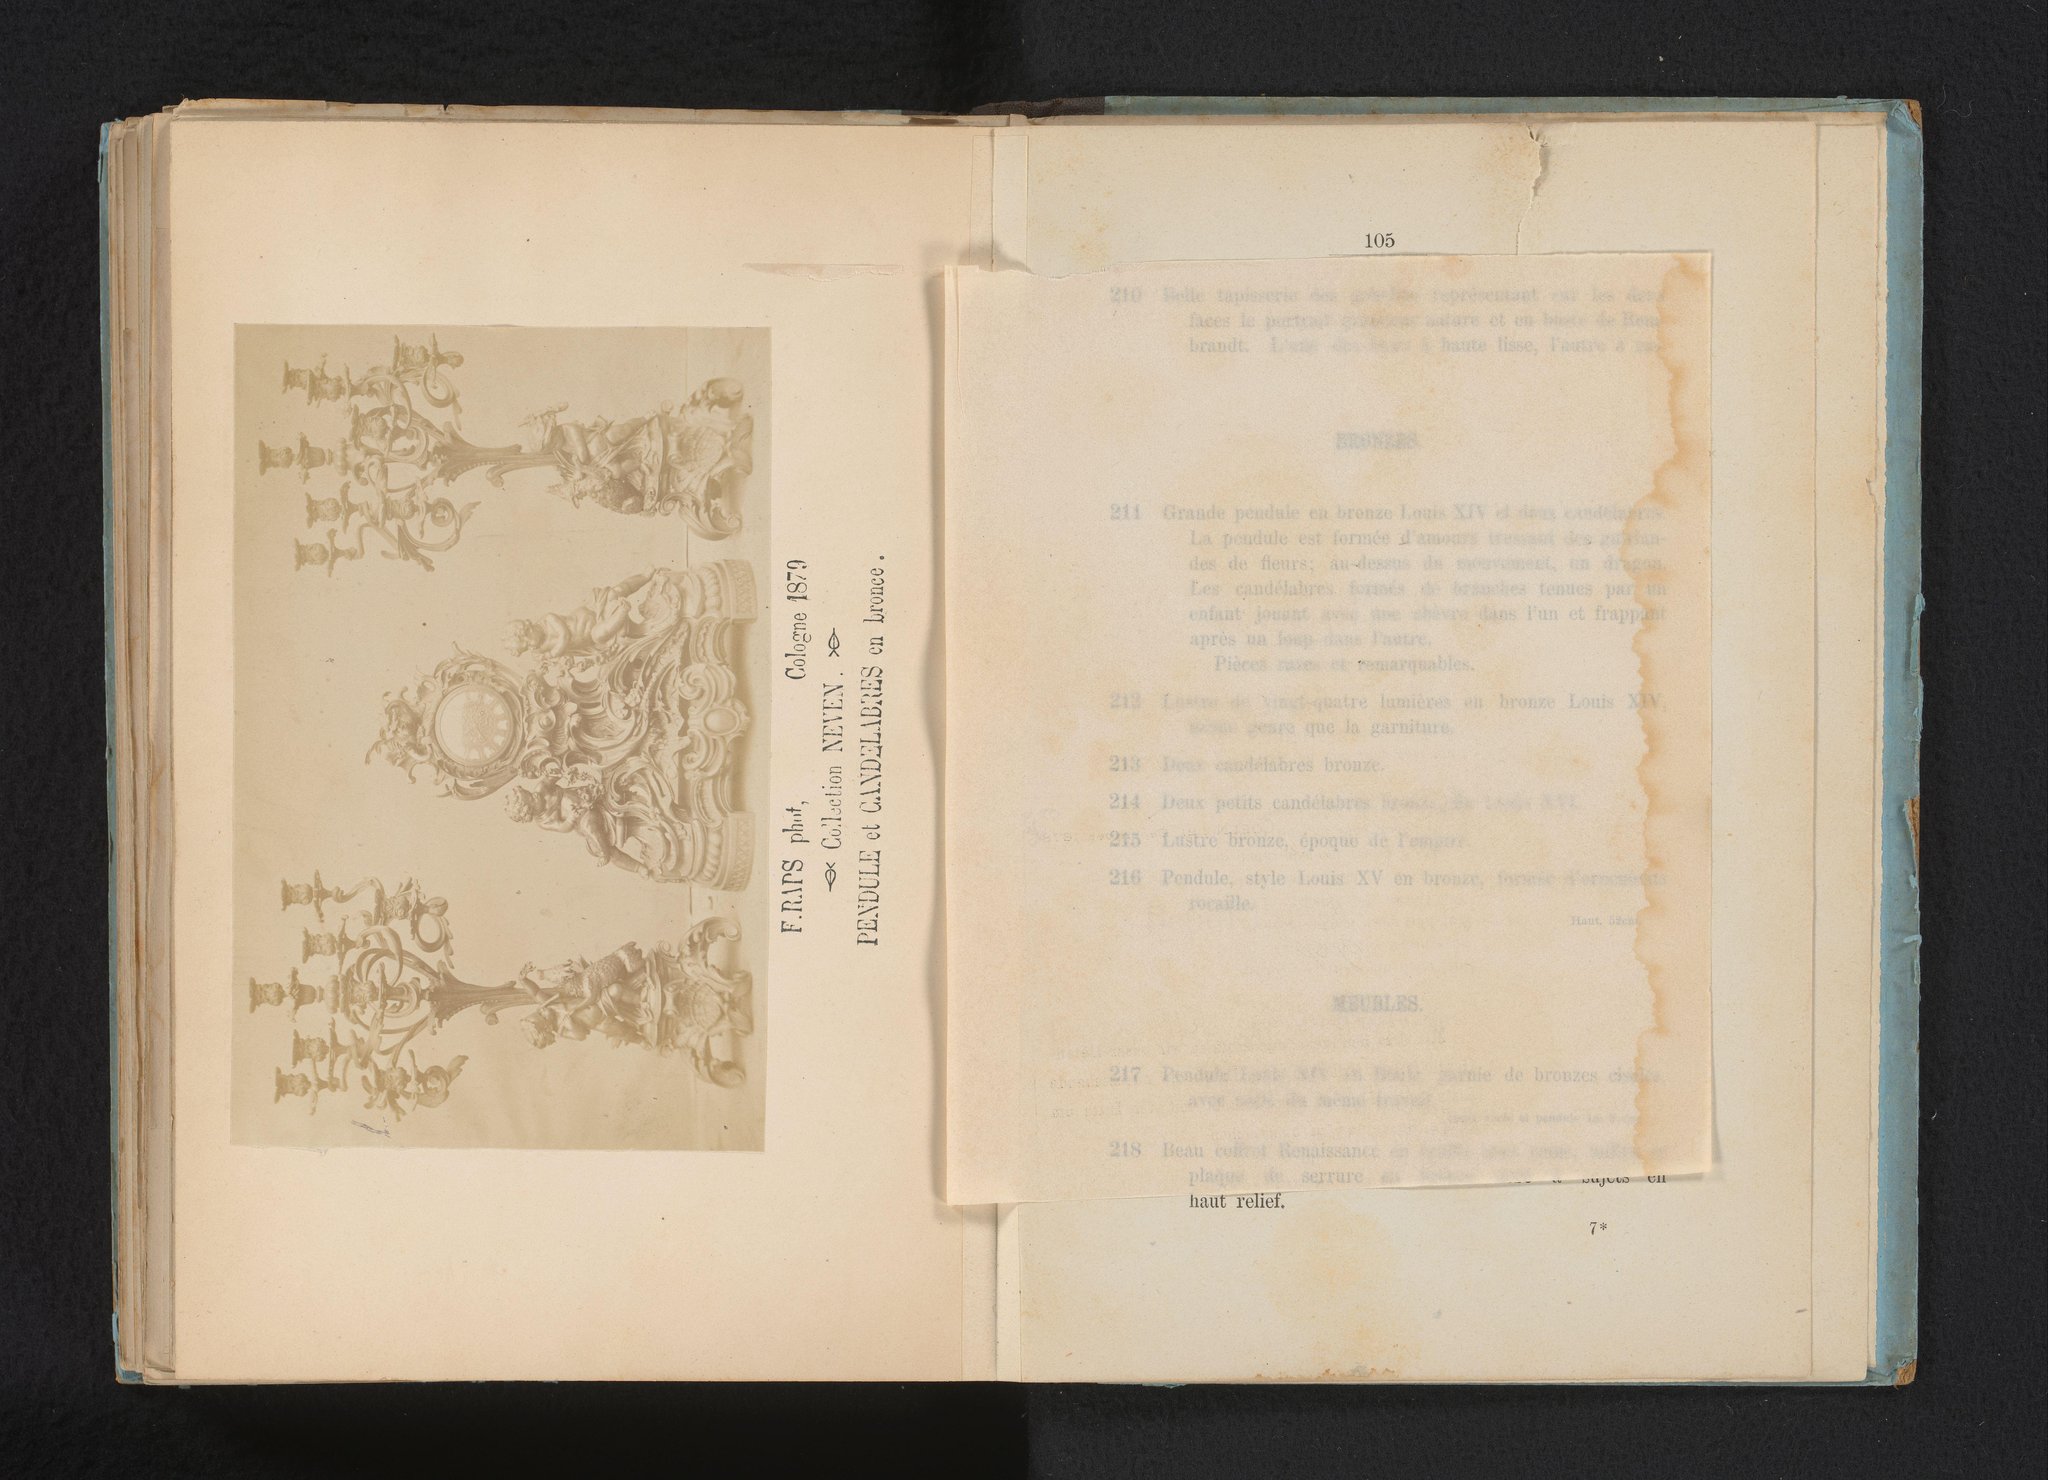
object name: photograph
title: Twee bronzen kandelaren en een klok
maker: friedrich raps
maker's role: fotograaf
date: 1879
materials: photographic support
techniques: albumen print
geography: cologne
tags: chandelier, candelabrum, clock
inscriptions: inscription: ‘Collection NEVEN/ Pendule et candelabres en bronce.’